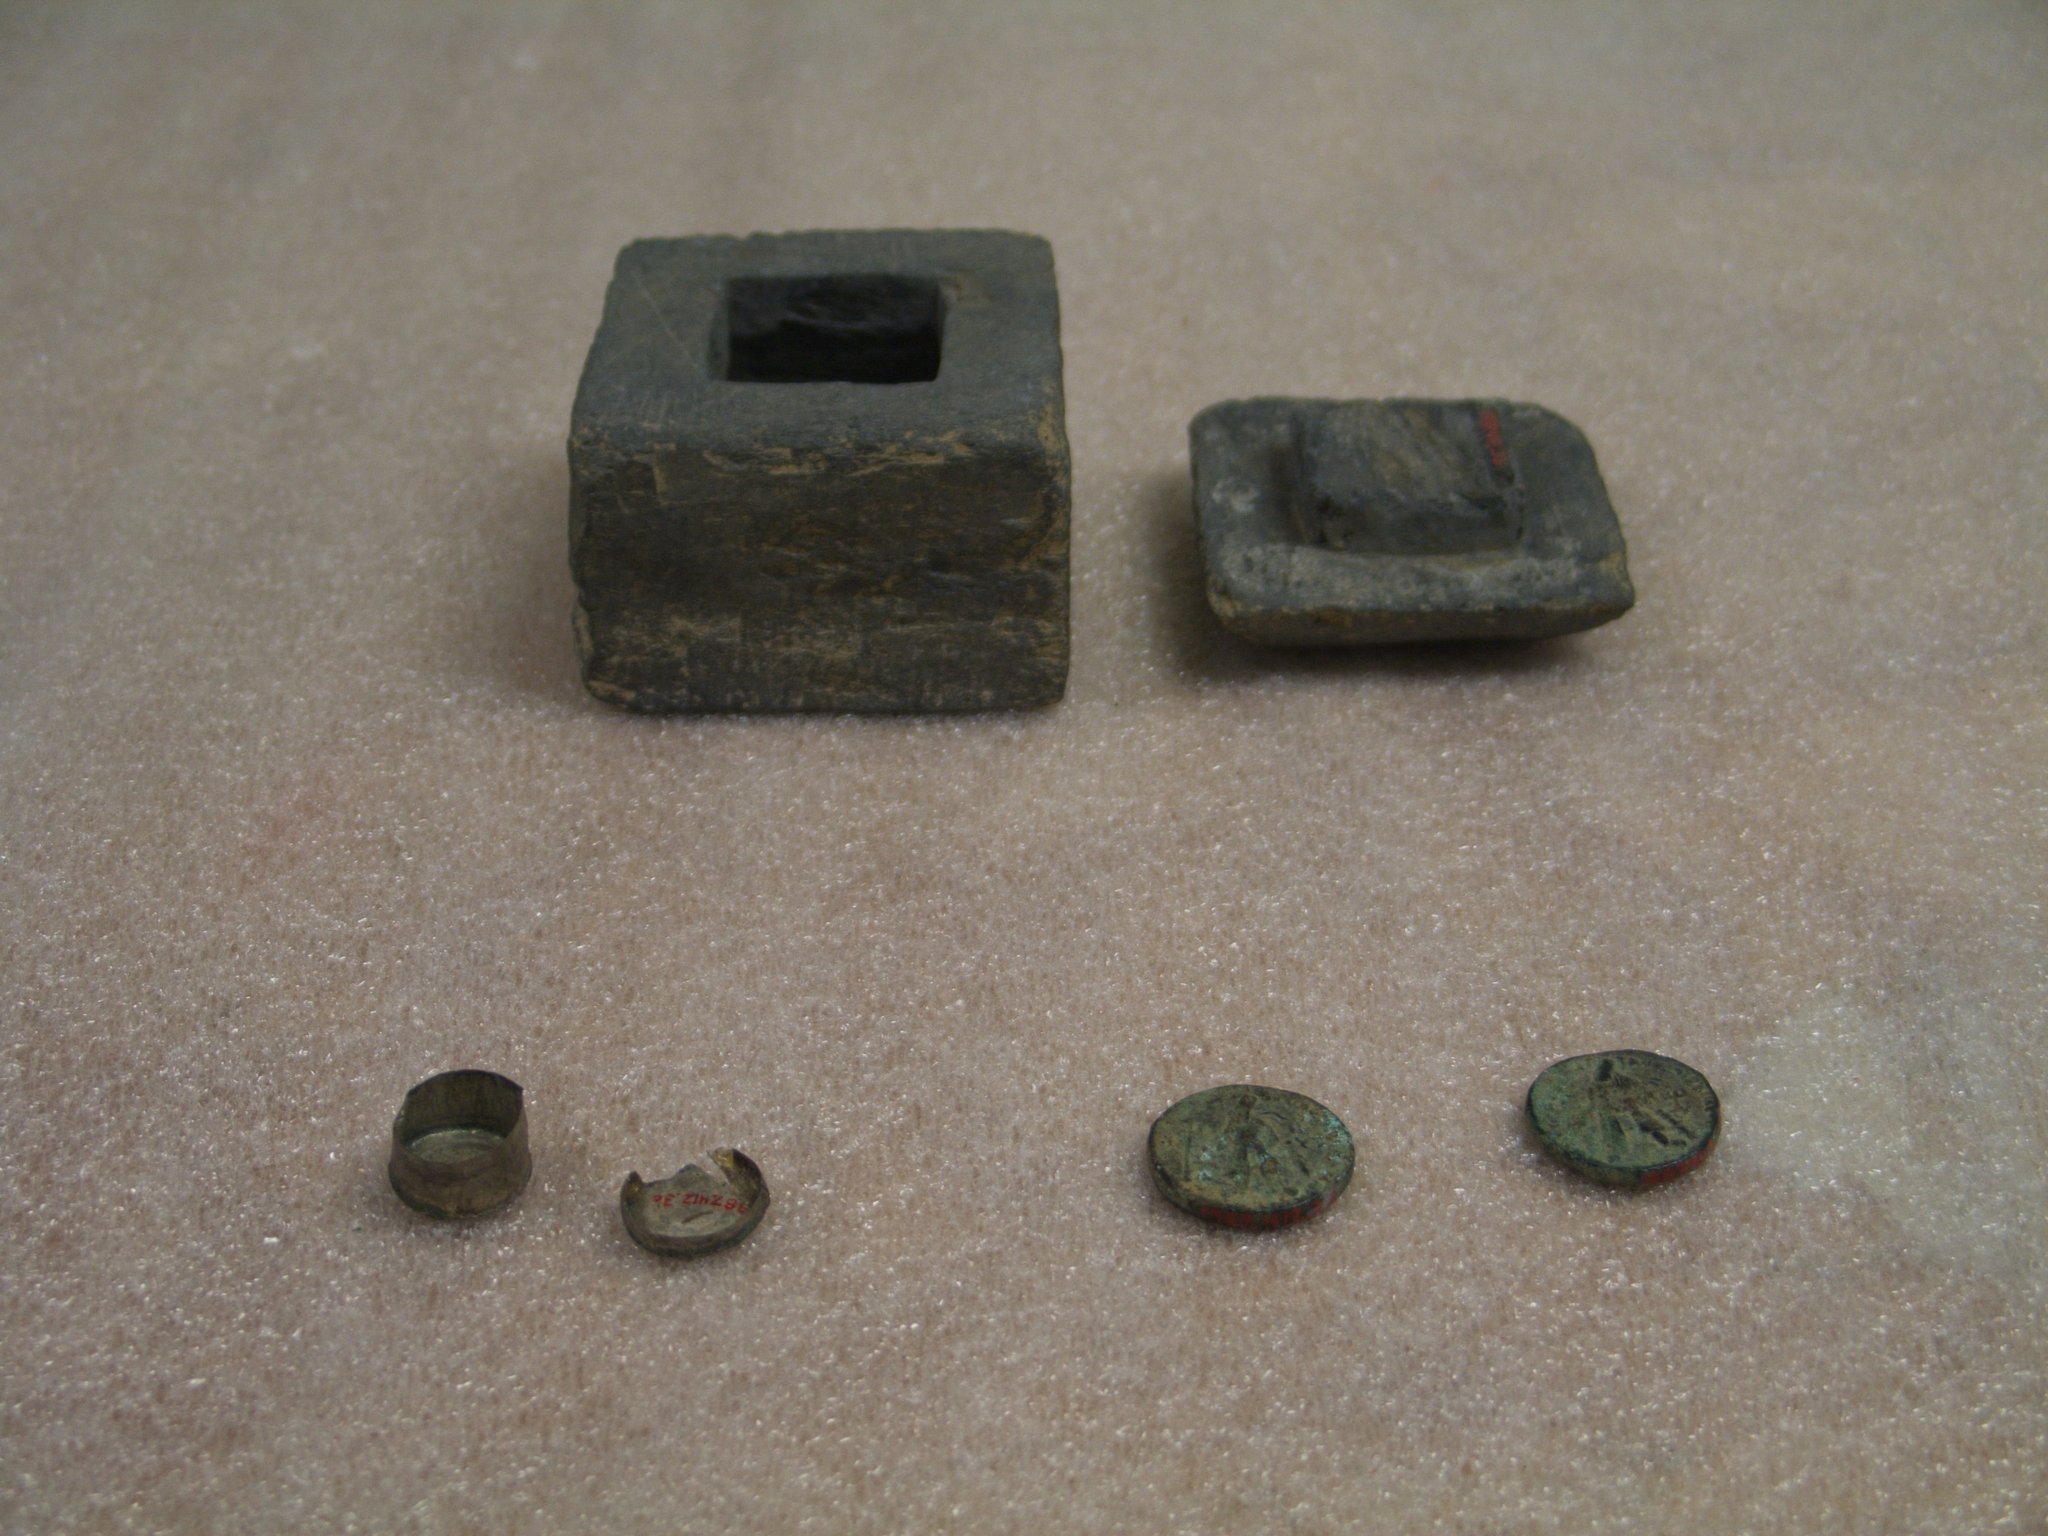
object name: reliquary with content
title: Reliquary with Contents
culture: gandhara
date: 101-300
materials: copper, stone, silver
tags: gandhara